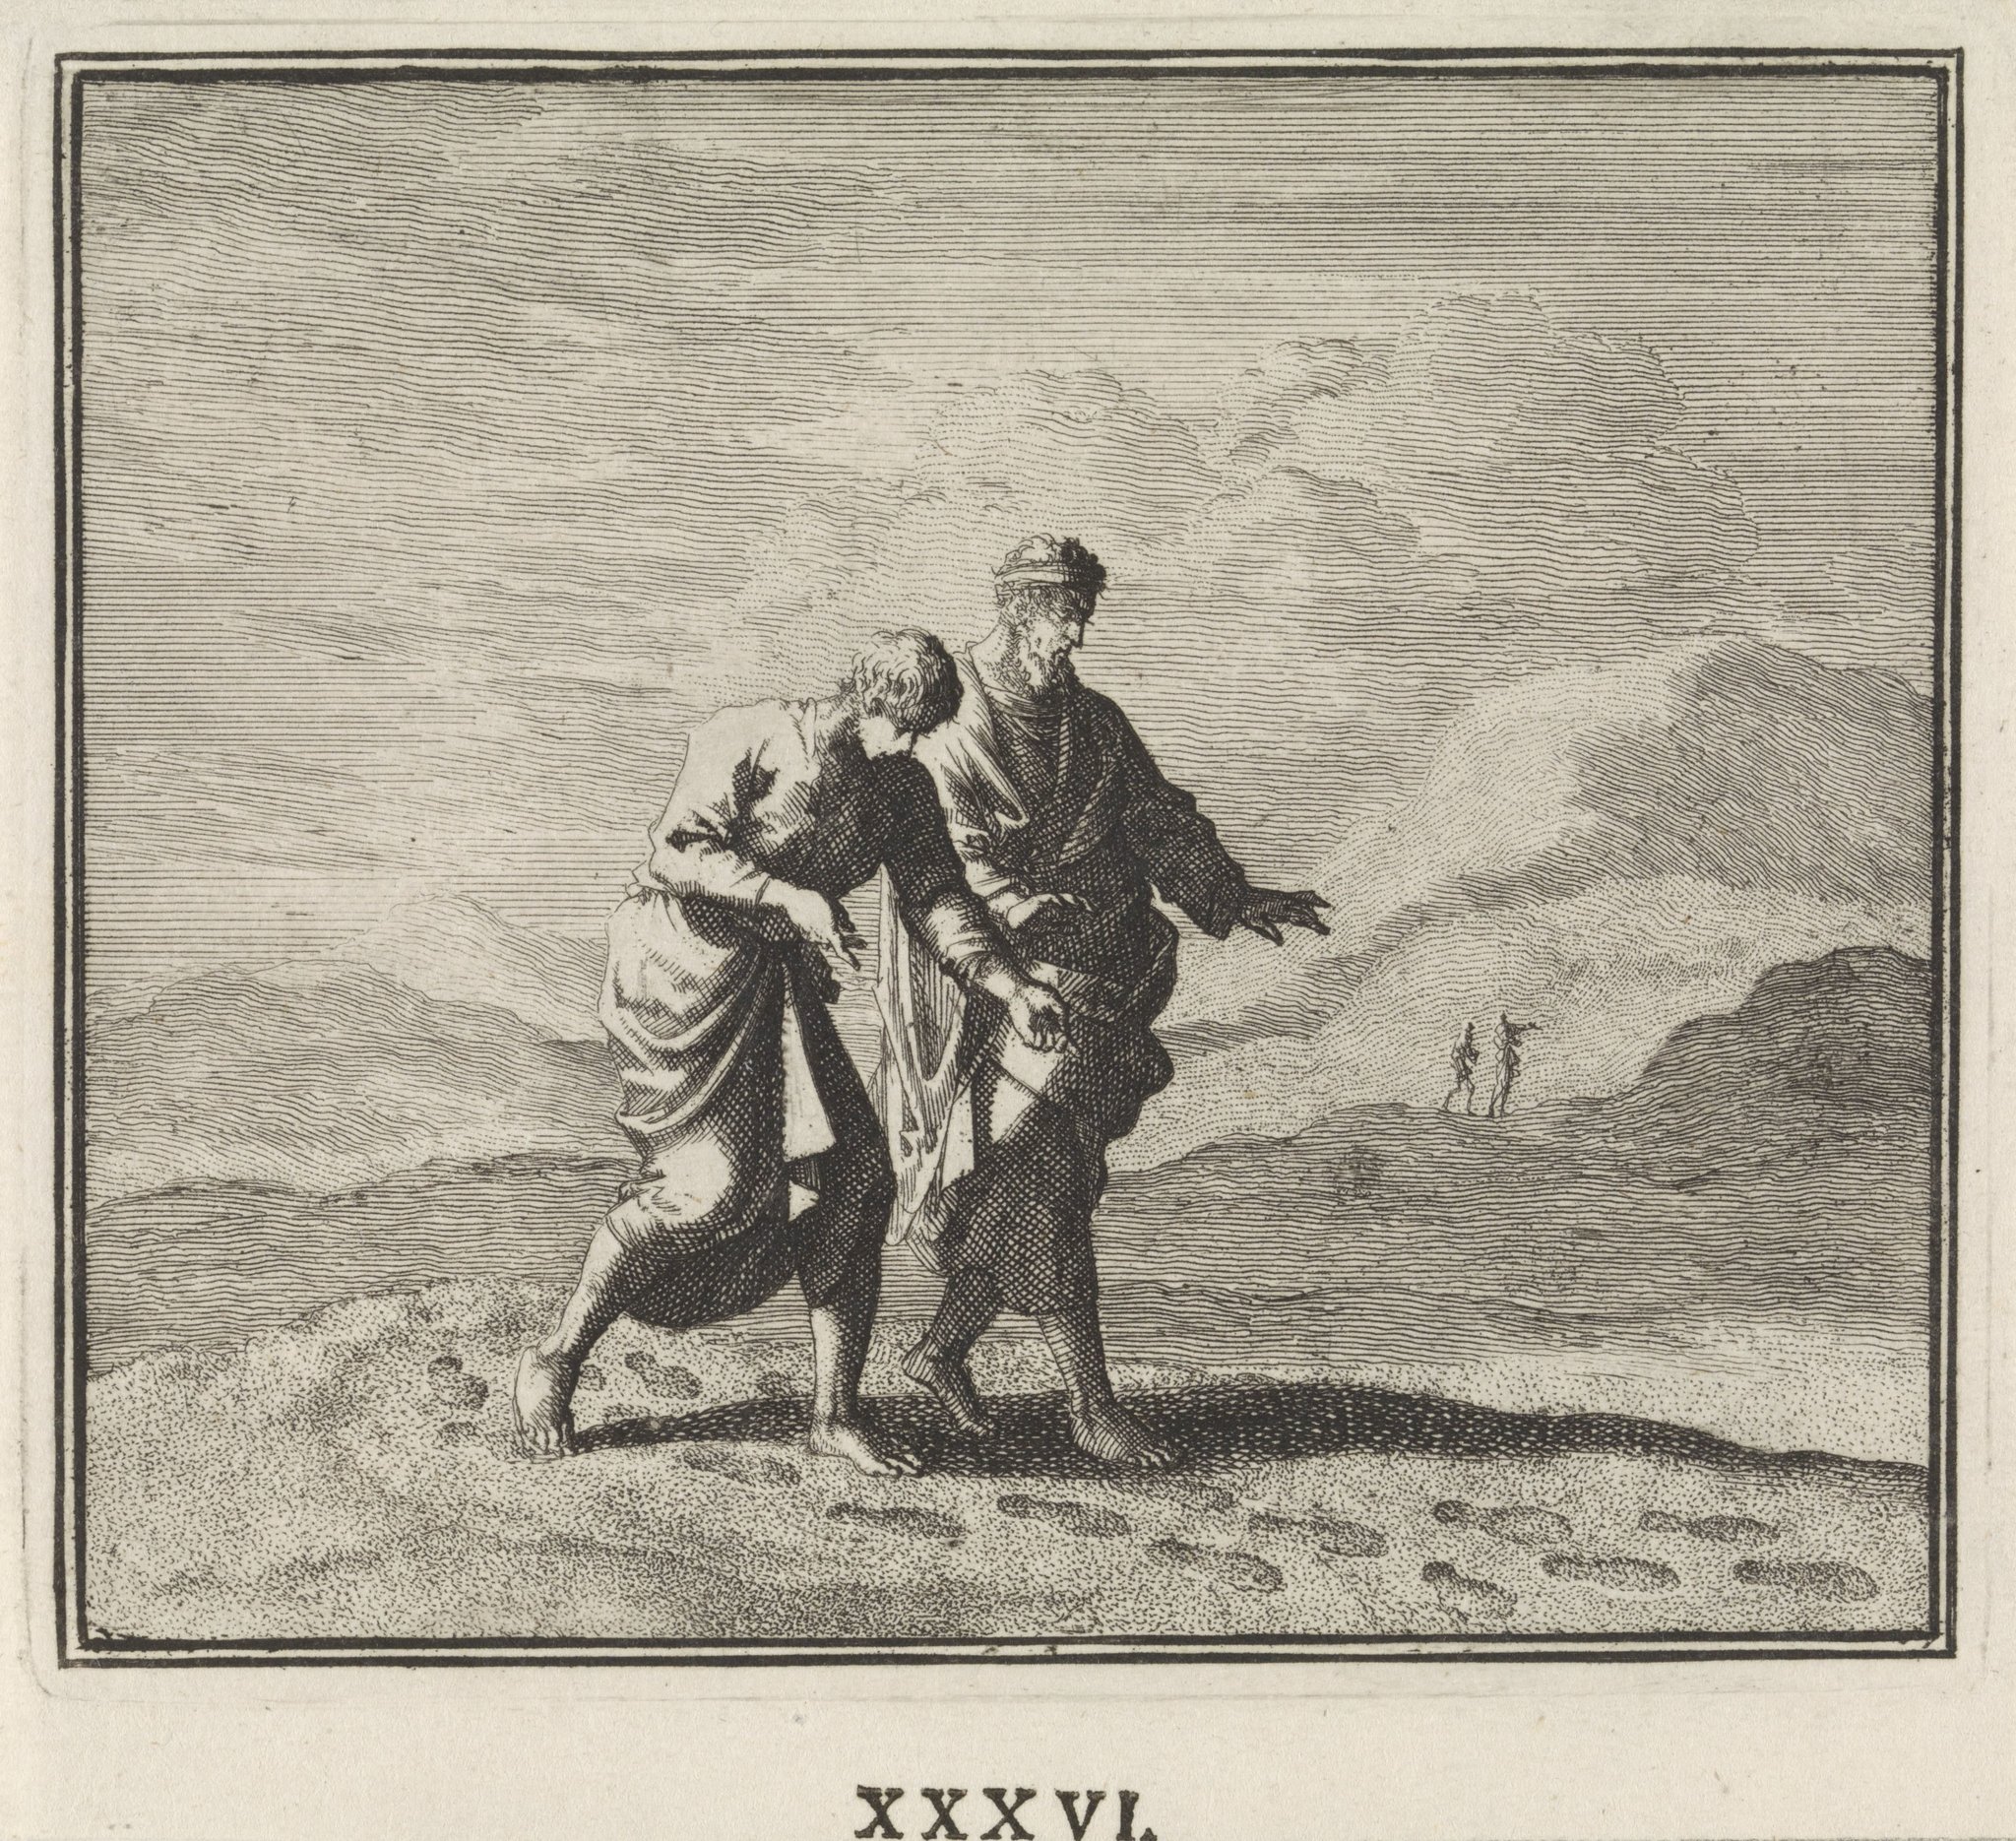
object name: print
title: Twee reizigers in een woestijn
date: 1695-1705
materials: paper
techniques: etching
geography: amsterdam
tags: foot-print, track, desert (+ landscape (in the non-temperate zone) with figures, staffage), sand (soil type), 'en route', traveller under way, abstract ideas and concepts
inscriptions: collector's mark: Lugt 2228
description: Boekillustratie voor Weigel, Christoph. Ethica Naturalis seu Documenta Moralia e Variis rerum Naturalium proprietatibus Virtutum Vitiorumq symbolicis imaginibus collecta. Neurenberg: Christoph Weigel: c. 1700.